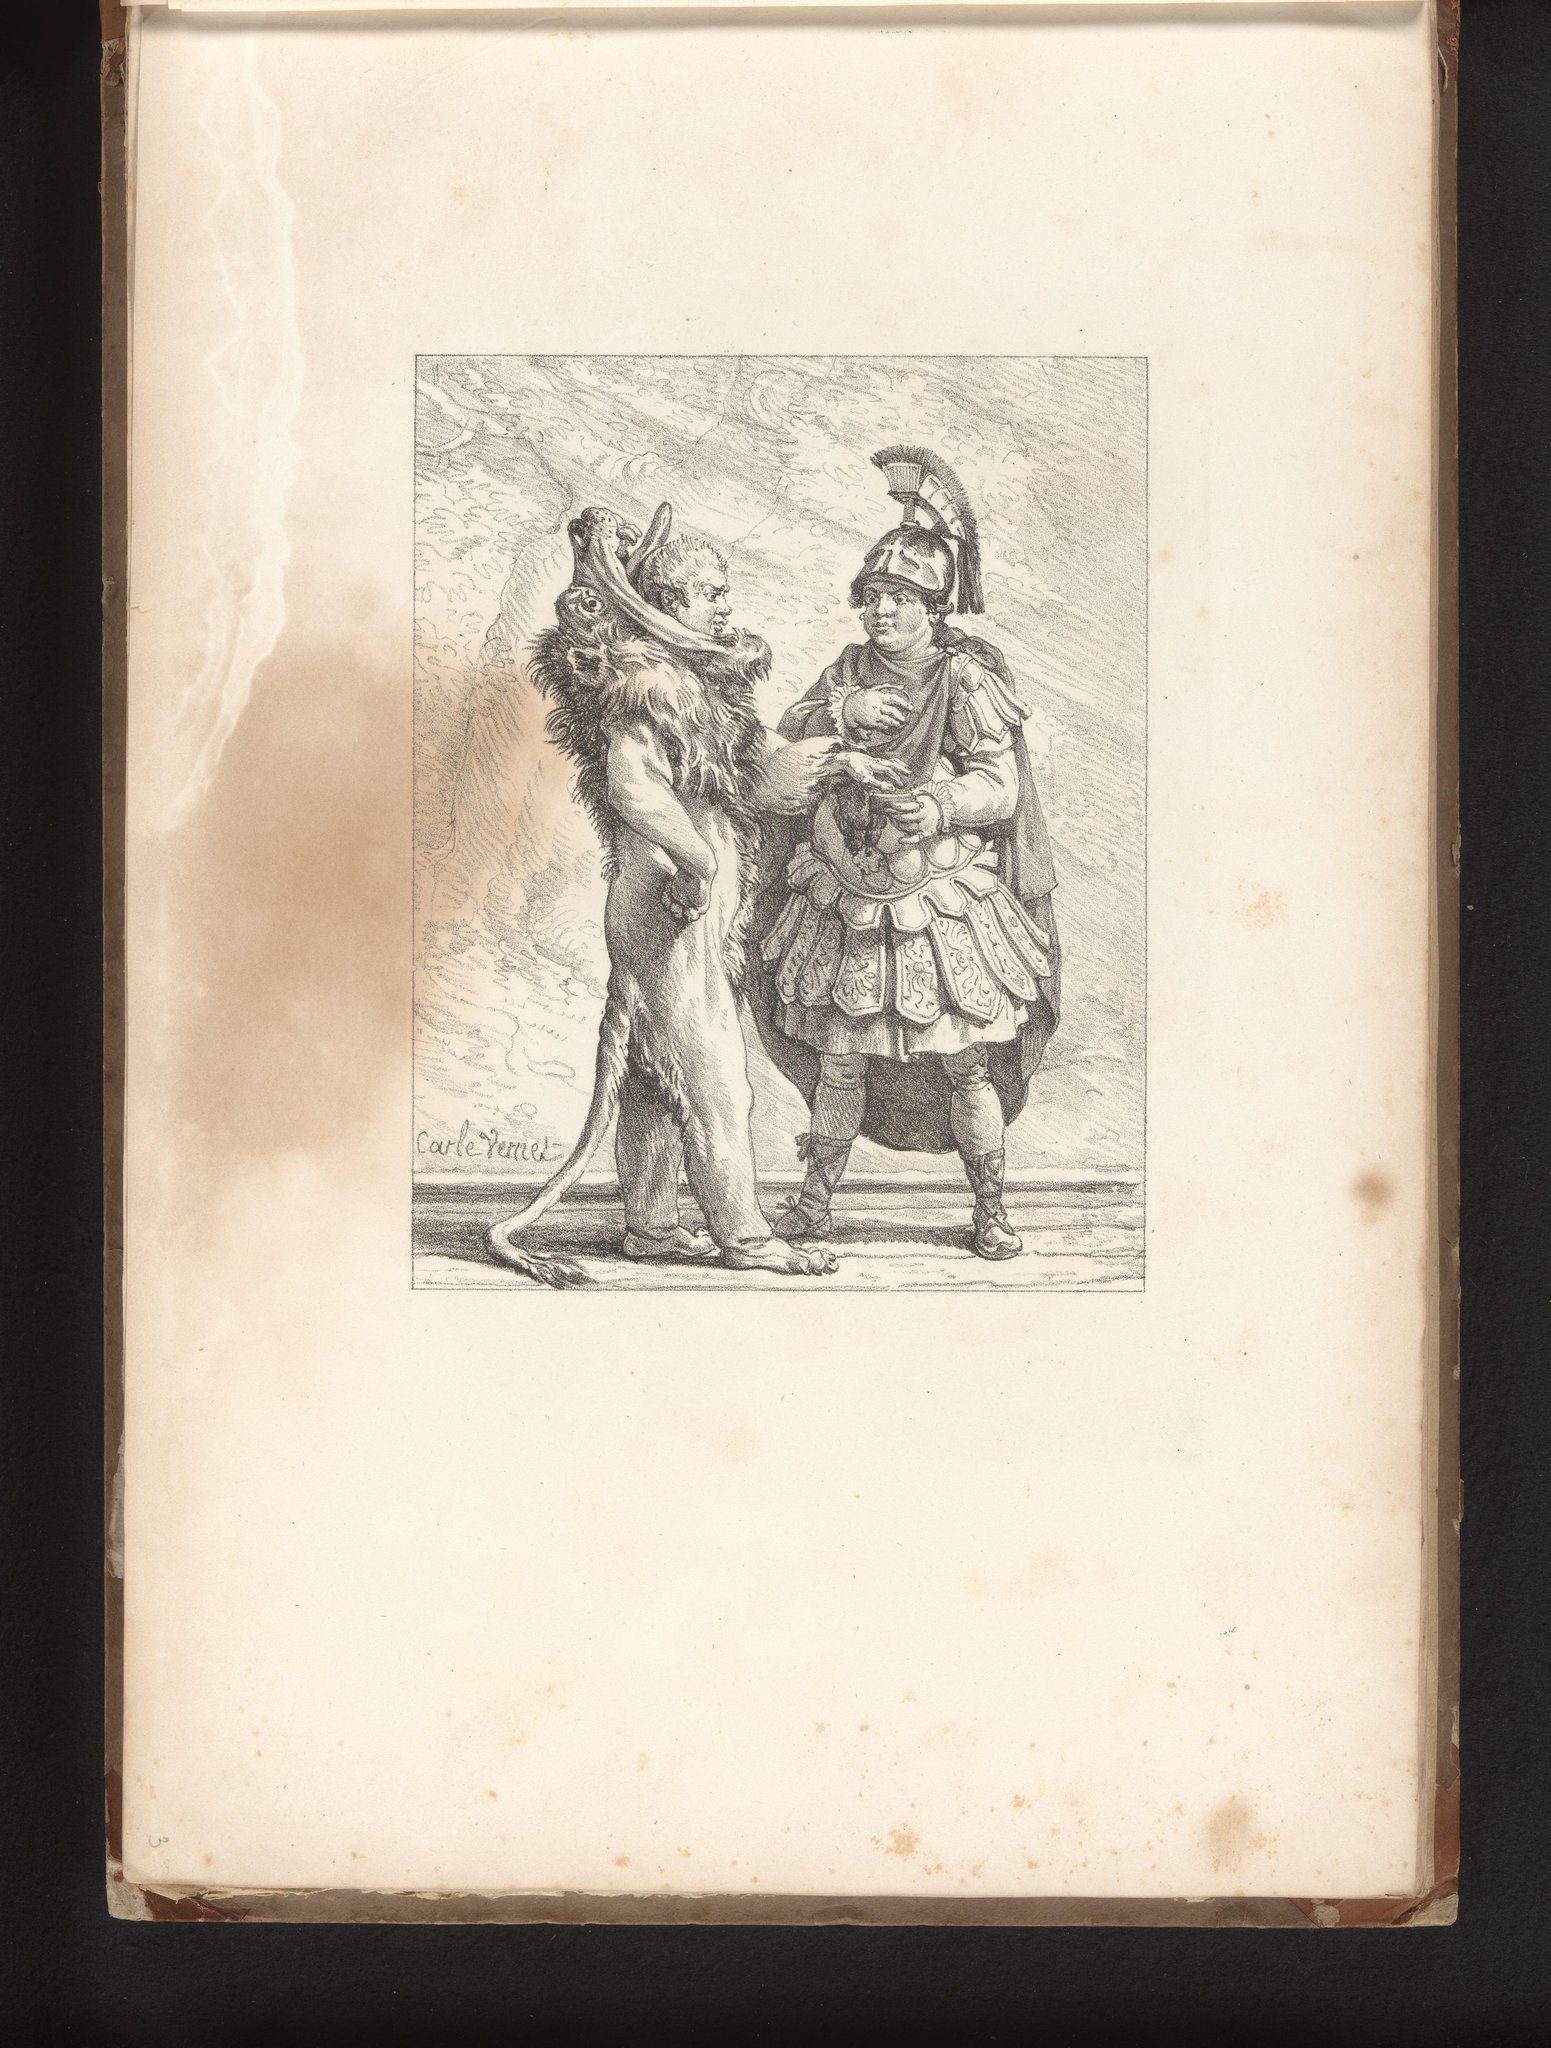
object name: album leaf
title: Serie lithografieën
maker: carle vernet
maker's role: draughtsman, print maker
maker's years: 1758-1836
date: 1818-1819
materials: paper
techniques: lithograph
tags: stage costume, snuff-box, group of actors, troupe; actors on the stage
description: Twee mannen in een leeuwenkostuum en de uitrusting van een Romeinse soldaat. Prent maakt deel uit van een album.